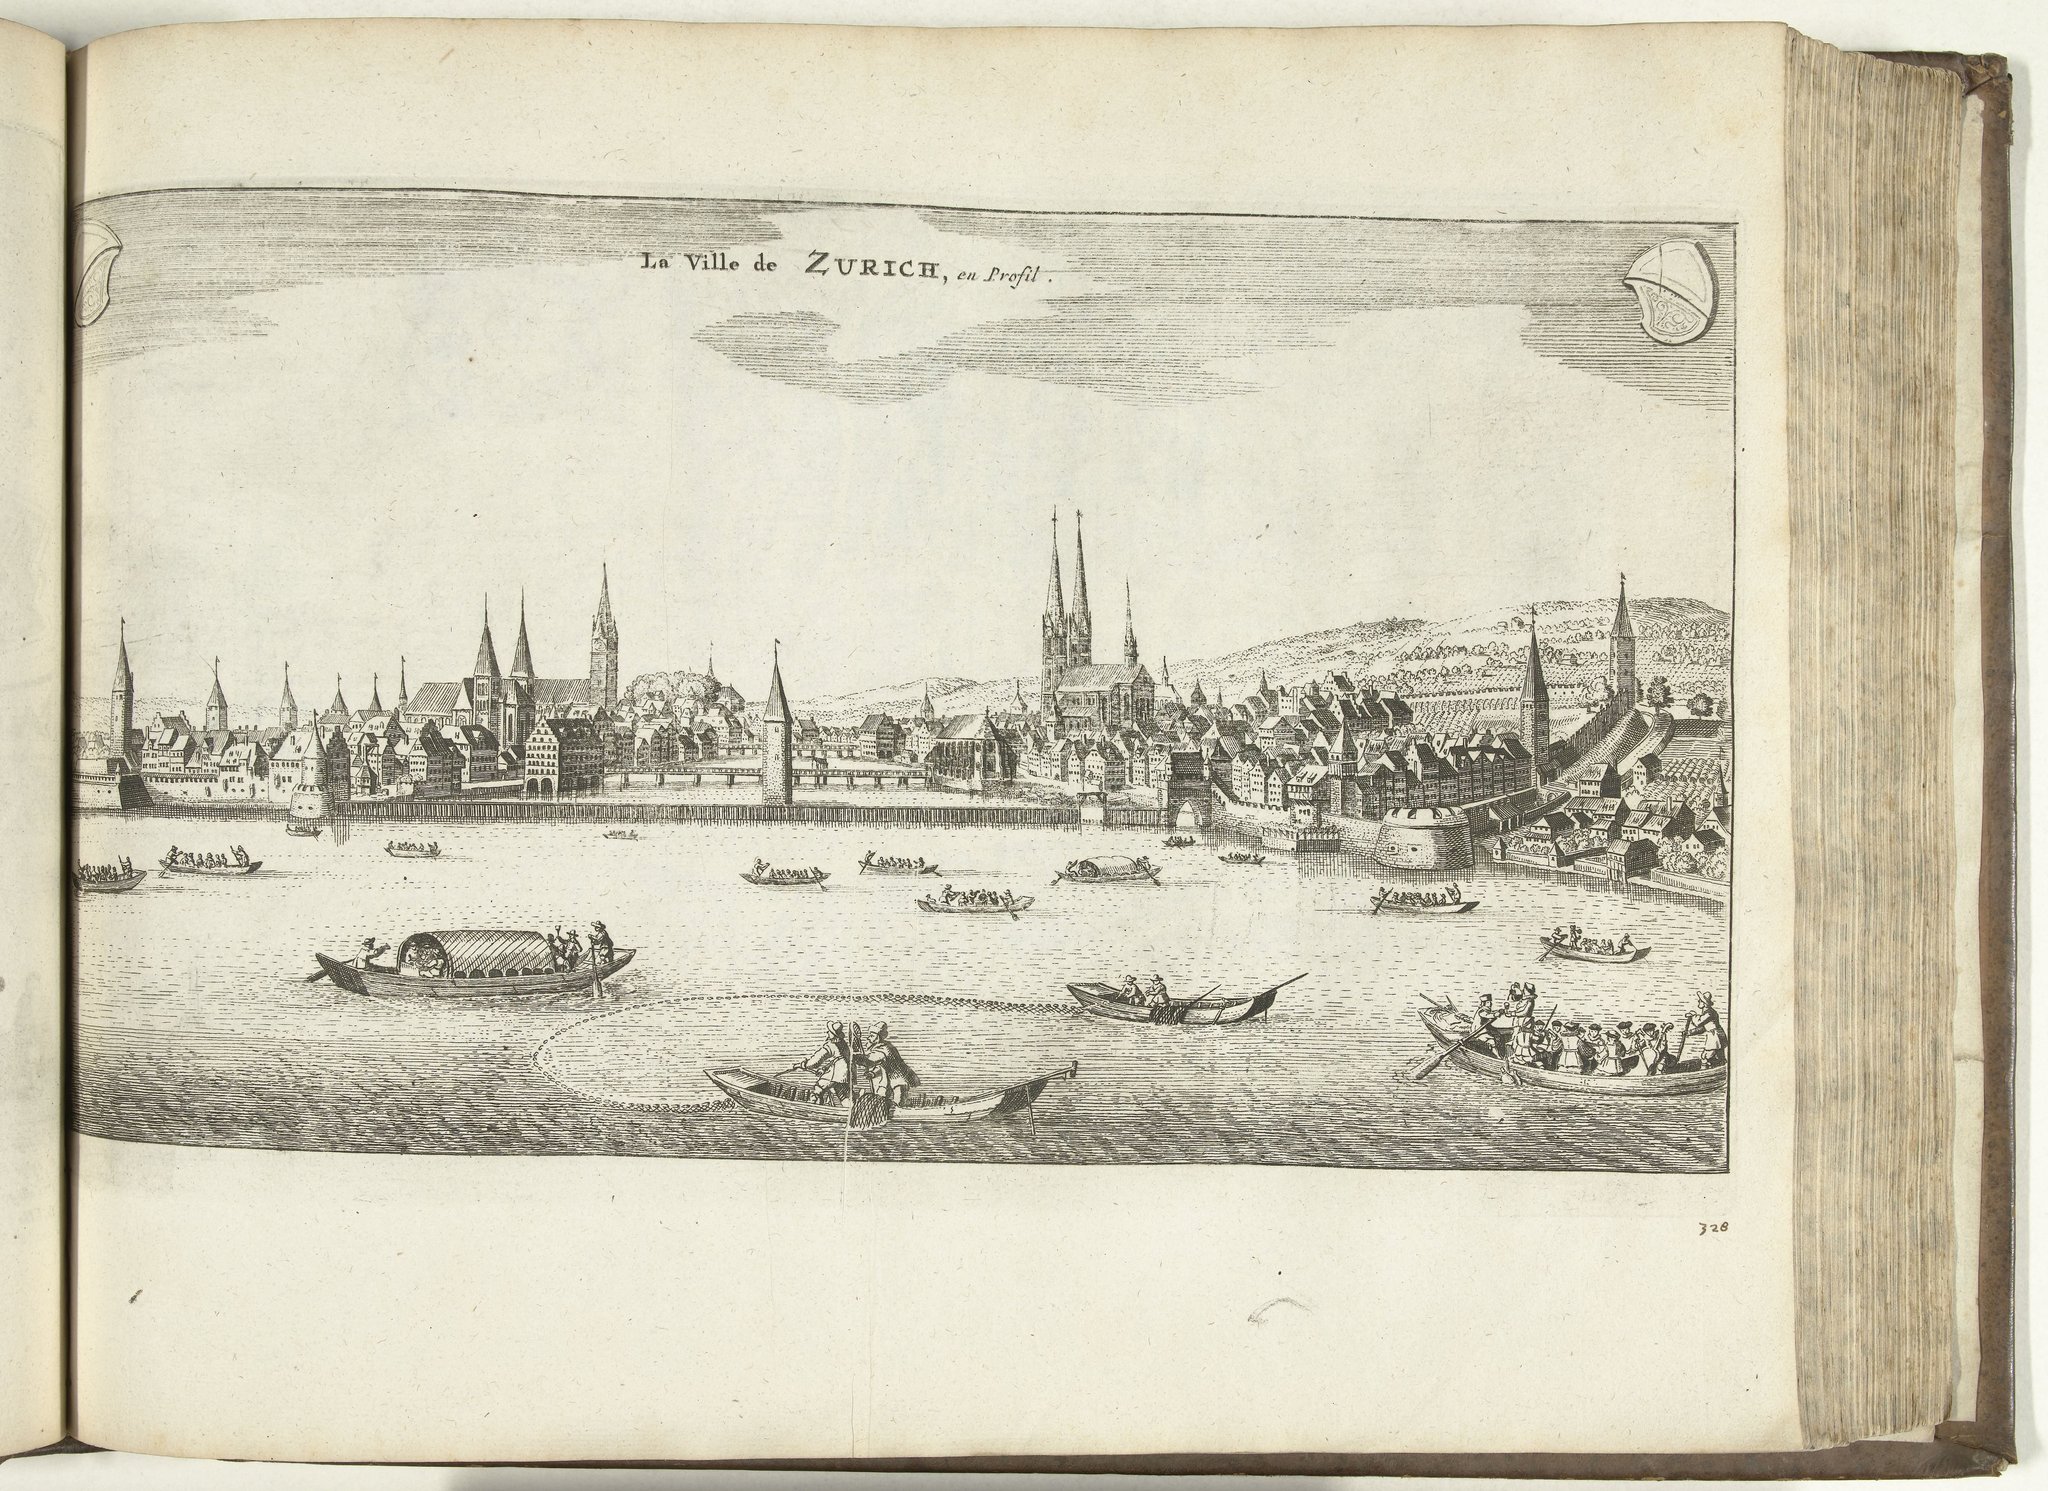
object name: print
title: Gezicht op Zürich, 1726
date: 1726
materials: paper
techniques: etching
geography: northern netherlands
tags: zürich (stad), spaanse successieoorlog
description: Profiel van Zürich, op de voorgrond bootjes op het water. Plaat nr. 328 in deel XIV van het prentwerk: Les Forces de l'Europe, Asie, Afrique et Amerique ... Comme aussi les Cartes des Côtes de France et d'Espagne uit 1726, dit tweede deel met 271 met de hand genummerde platen van vermaarde sterke steden en vestingen in het kader van de Spaanse Successieoorlog 1701-1713. Voor het merendeel zijn deze platen gekopieerd naar de anonieme Franse platen van vermaarde sterke steden en vestingen: in Les forces de l'Europe en in: Le theatre de la guerre, dans les Pays-Bas, beide oorspronkelijk uitgegeven door Nicolas de Fer te Parijs (1693-1697) in het kader van de Negenjarige Oorlog. Titel in het Frans.